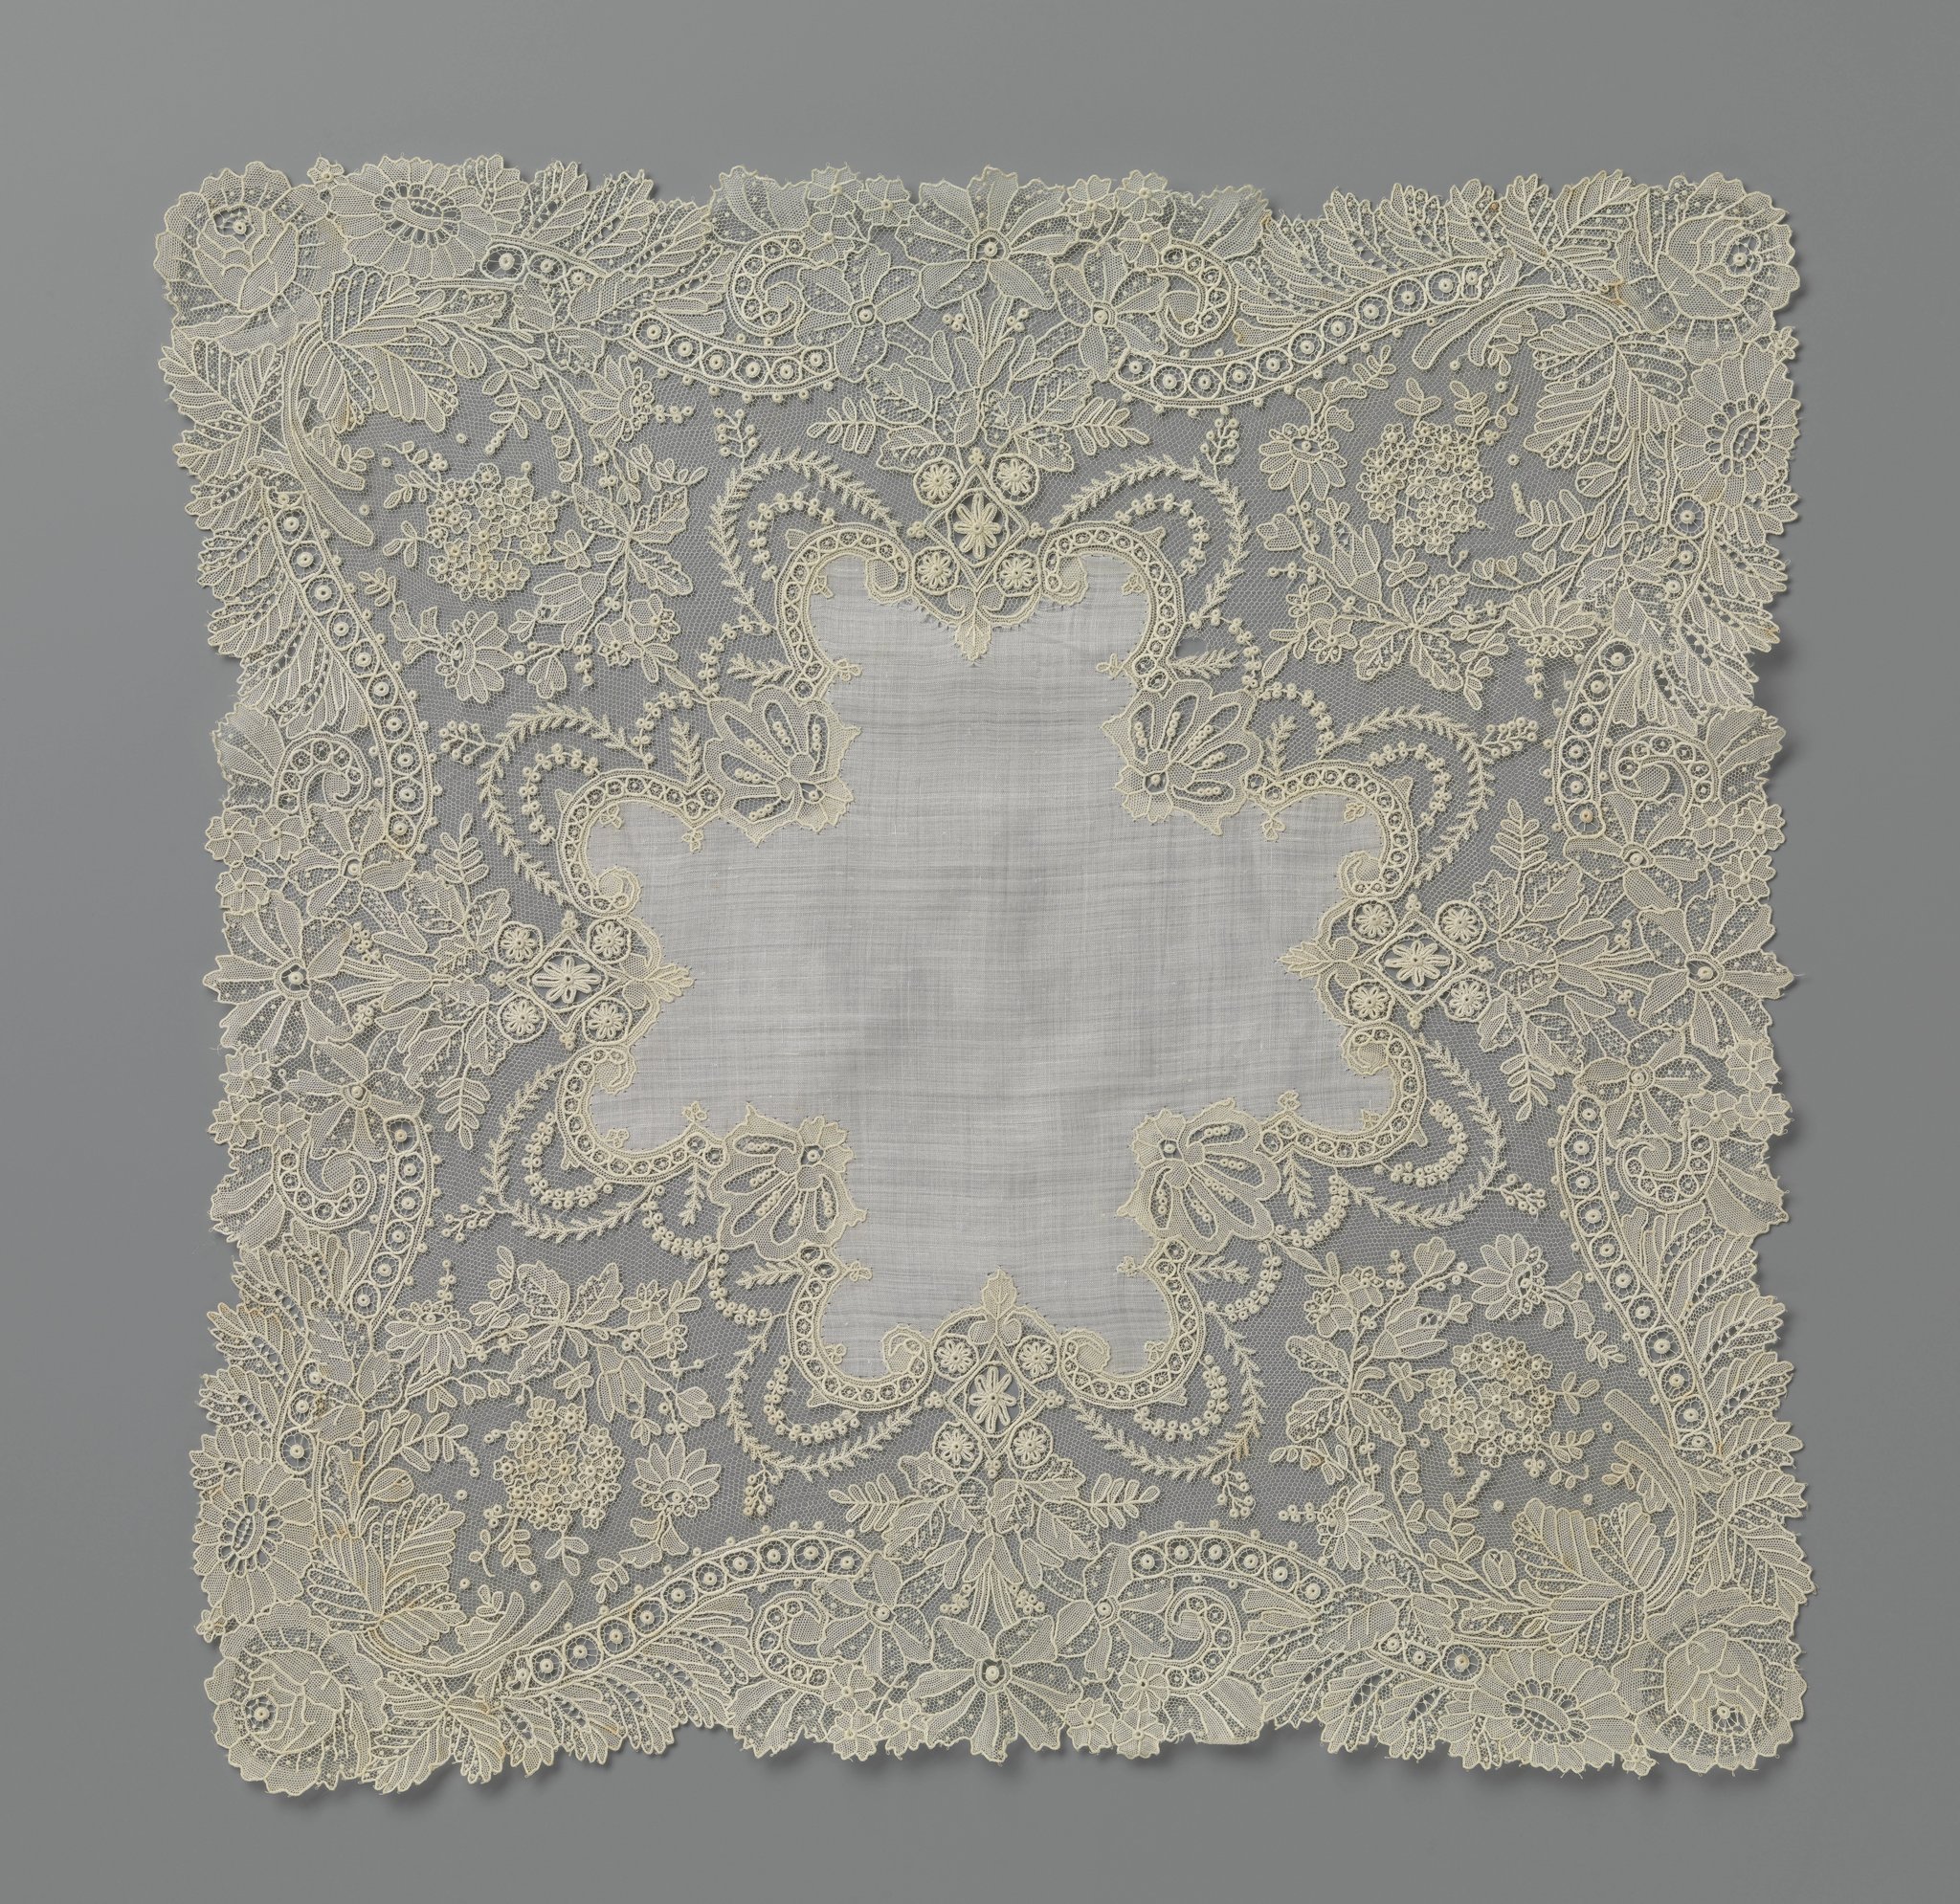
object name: handkerchief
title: Zakdoek met een rand van naaldkant met vier palmetjes en vier ruitjes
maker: Anonymous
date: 1880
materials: linen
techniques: lace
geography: brussels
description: Zakdoek met een rand van naturelkleurige naaldkant, Brusselse gaaskant. Om een batisten middenstuk in de vorm van een Malteser kruis loopt een brede kantstrook. Vier palmetjes en vier ruitjes staan langs de binnenrand, verbonden door fijne slingertjes. De hoeken worden gevormd door diepe schulpen met een vloeiende V-vormige voluut, die wordt oversneden door een c-vormige tak met een buitenwaarts gerichte roos en aster en een binnenwaarts gerichte sneeuwbal. Op het midden der zijden staan drie hangende lelies. De buitenomtrek is vrij recht.